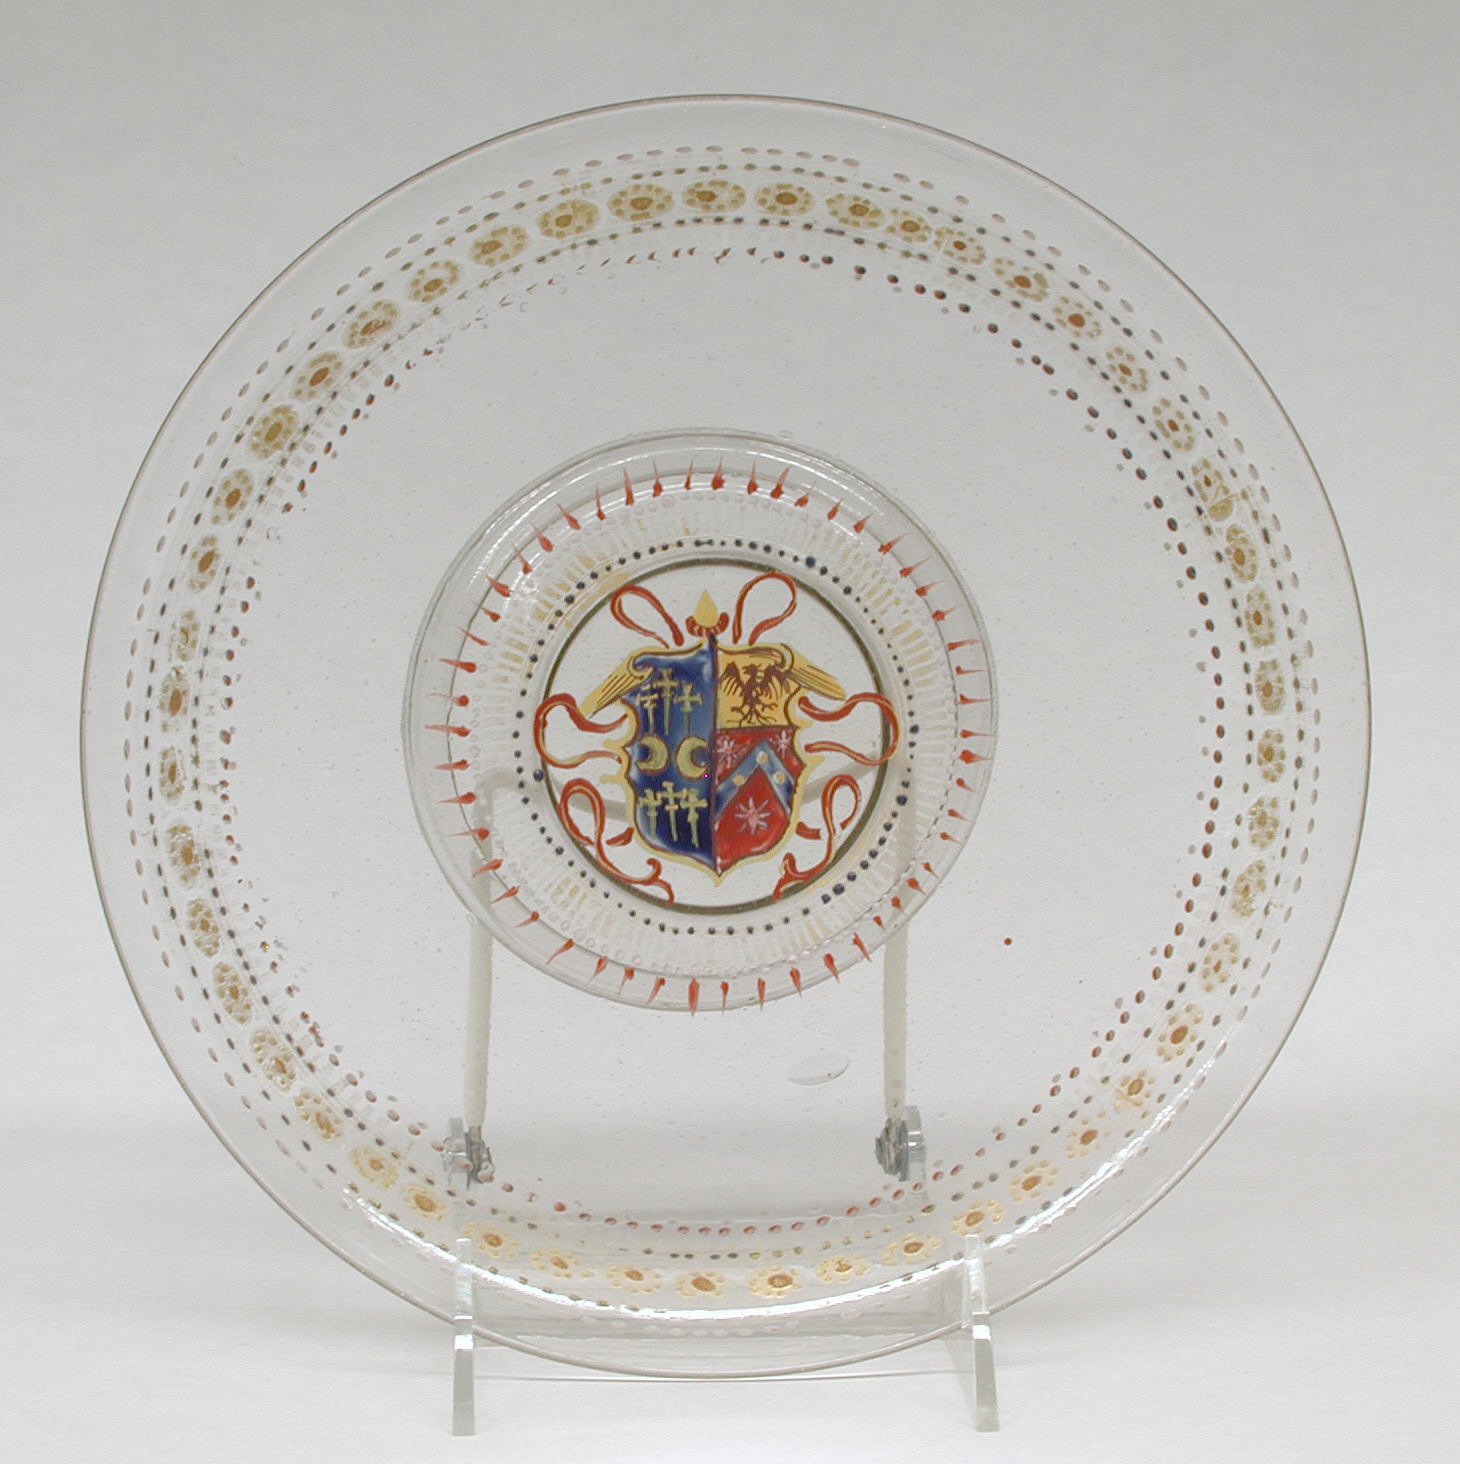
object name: tazza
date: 1501-1550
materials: glass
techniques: enamel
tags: coat of arms